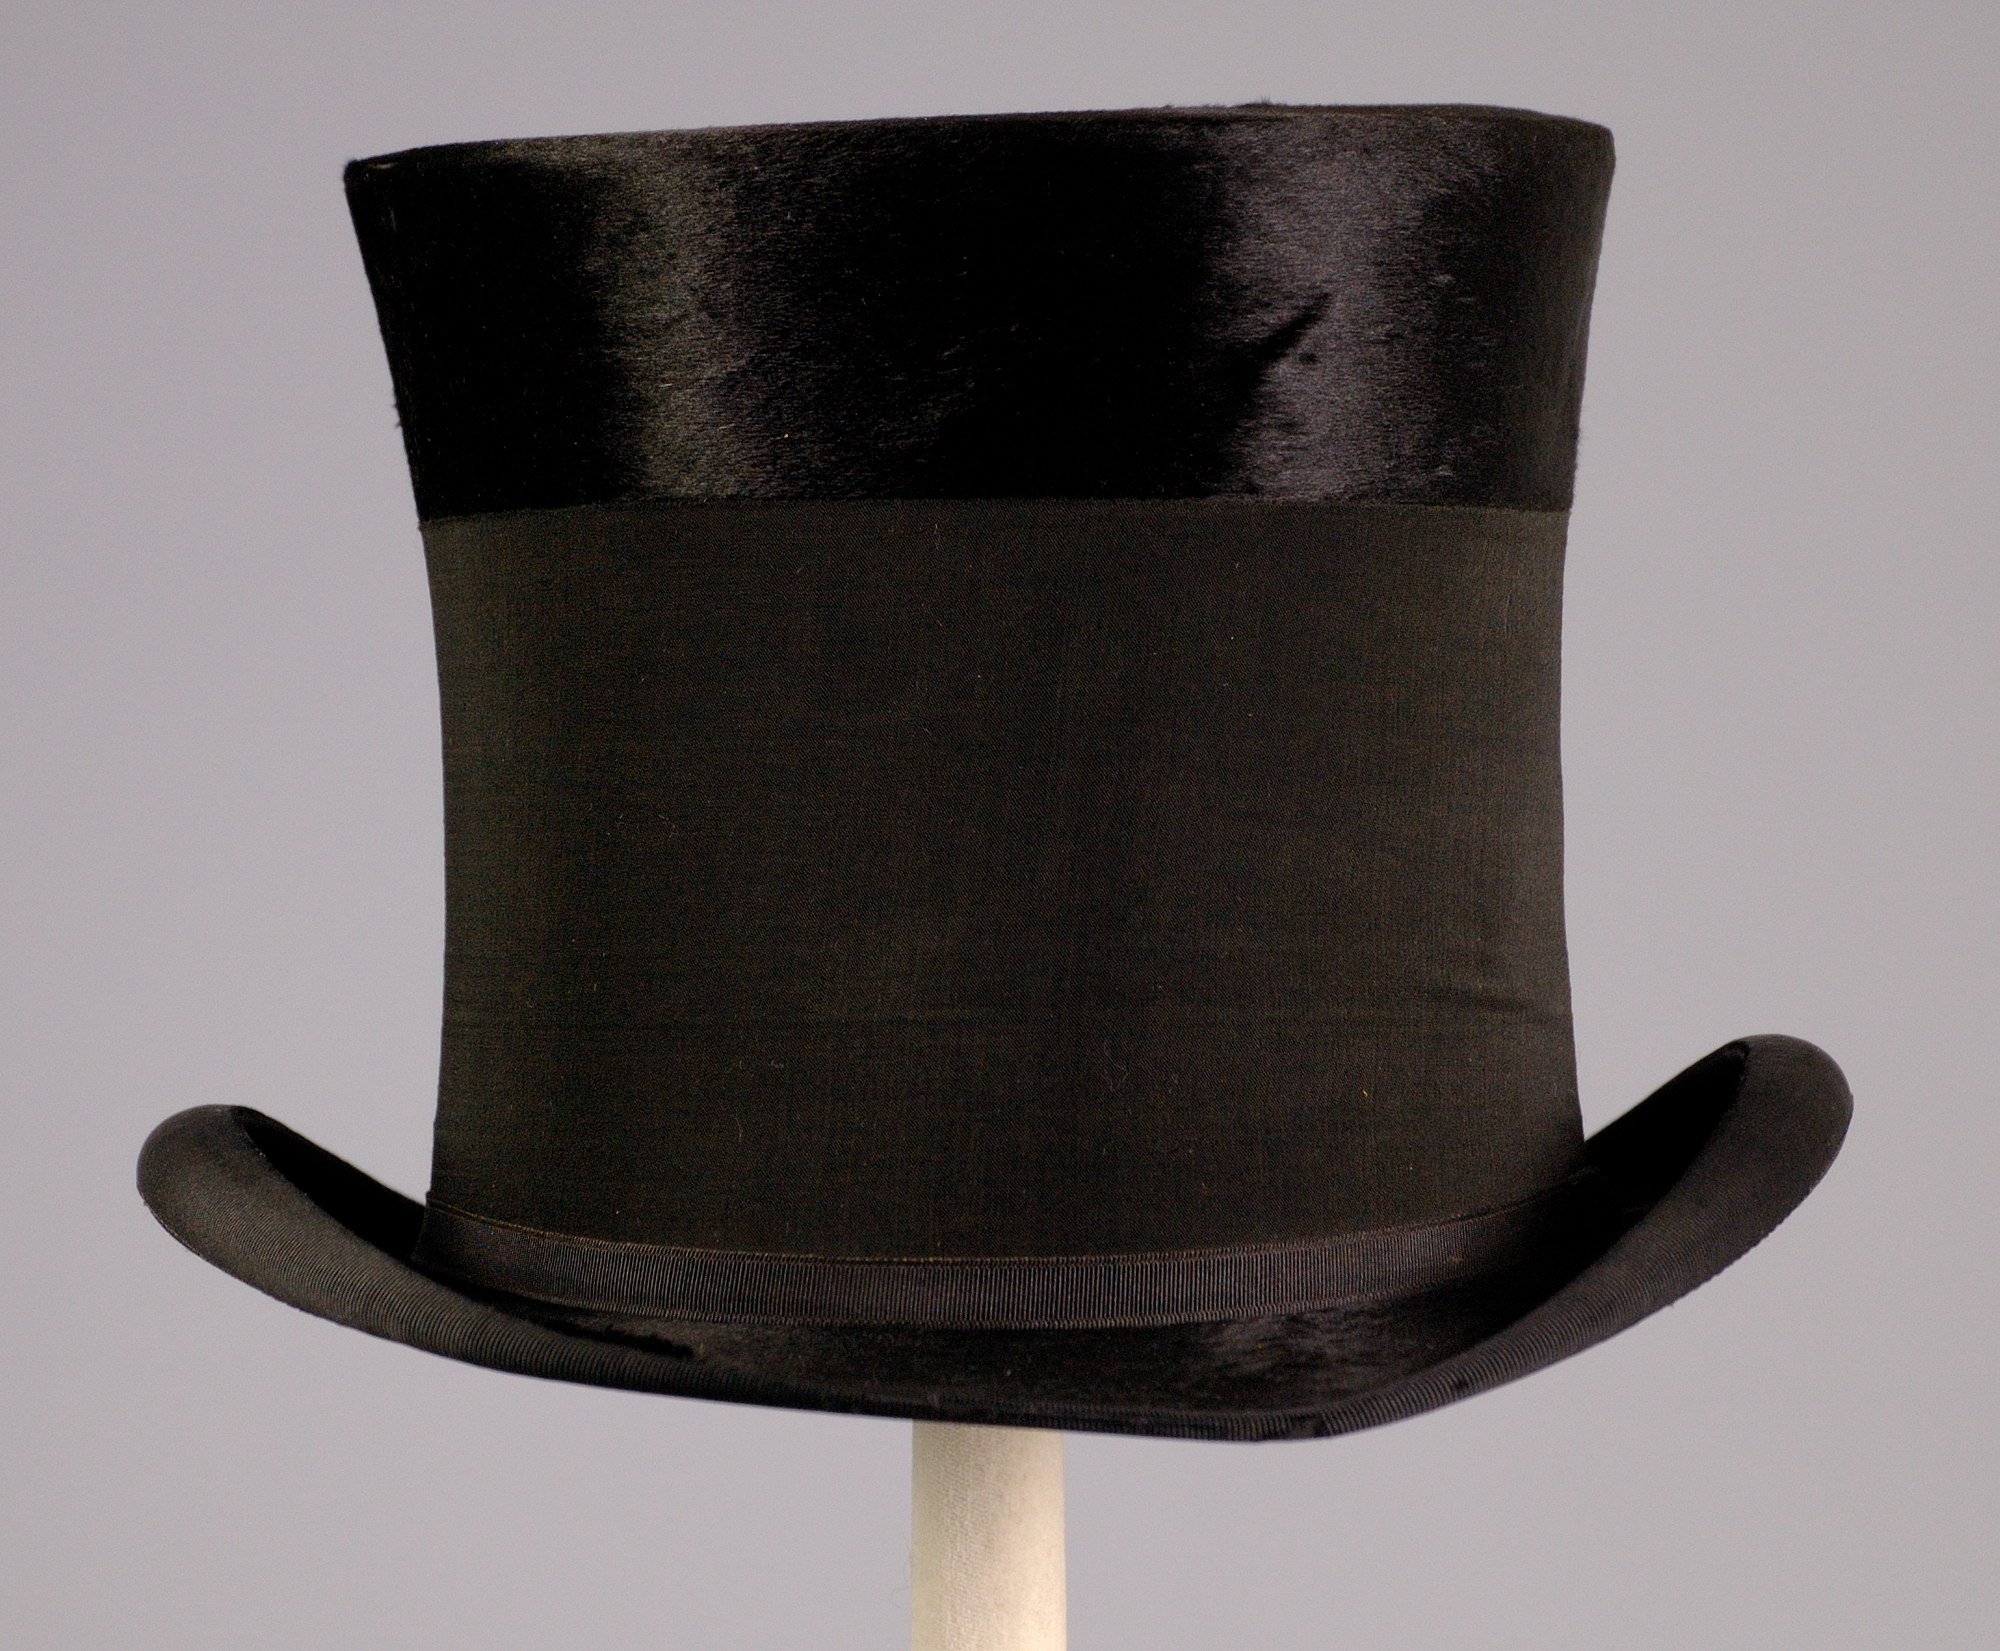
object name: mourning hat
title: Mourning top hat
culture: american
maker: knox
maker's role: maker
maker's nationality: american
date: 1890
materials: cotton, fur, silk